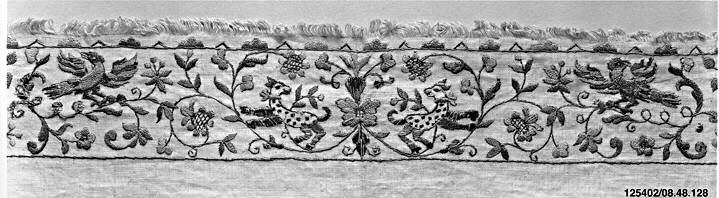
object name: towel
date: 1501-1600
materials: linen, metal thread, silk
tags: animals,birds,flowers